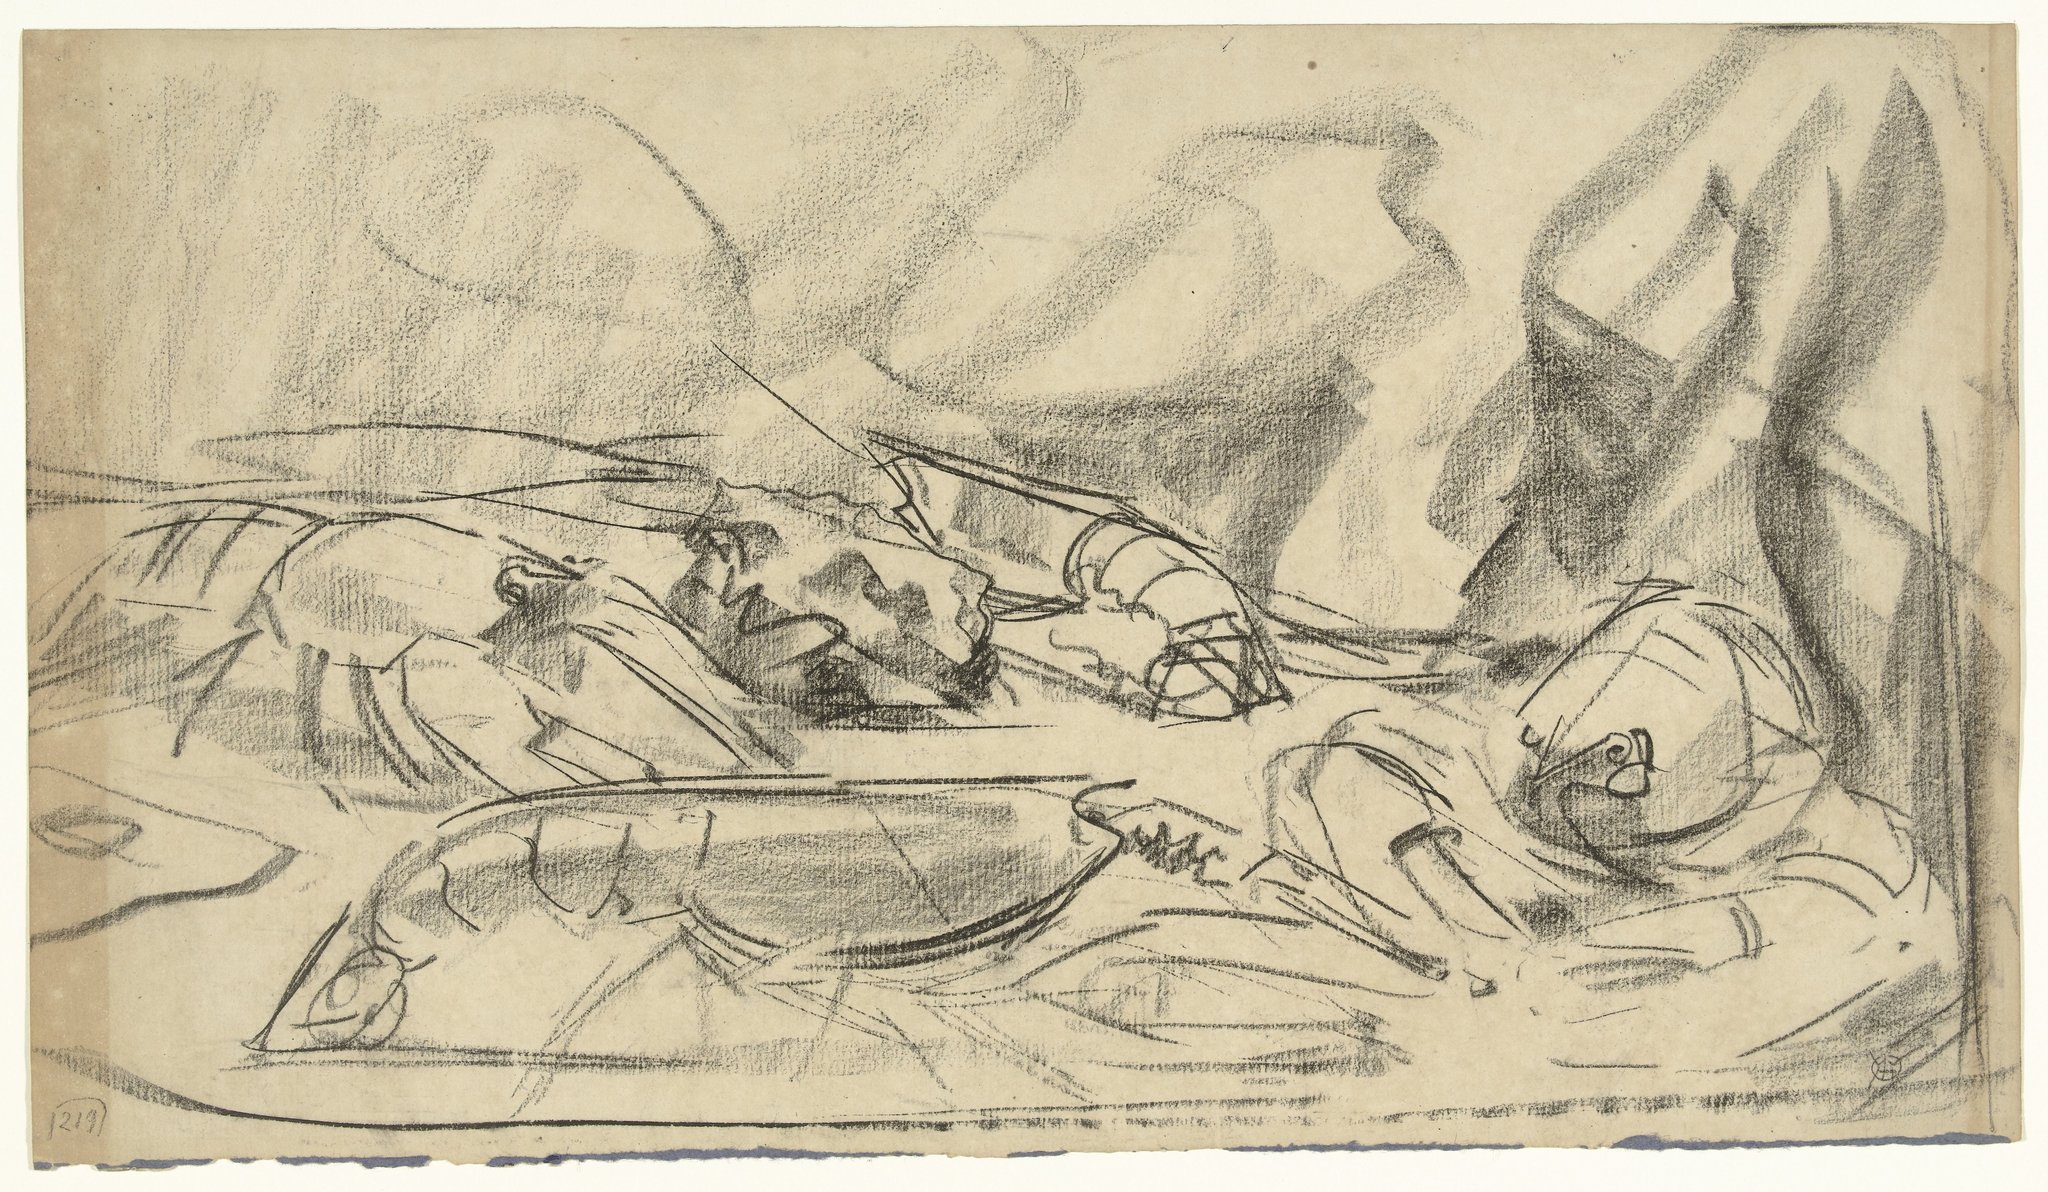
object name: drawing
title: Kreeften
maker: gerrit willem dijsselhof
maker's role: designer, draughtsman, print maker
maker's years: 1866-1924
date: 1876-1924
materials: chalk, paper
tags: crustaceans: lobster